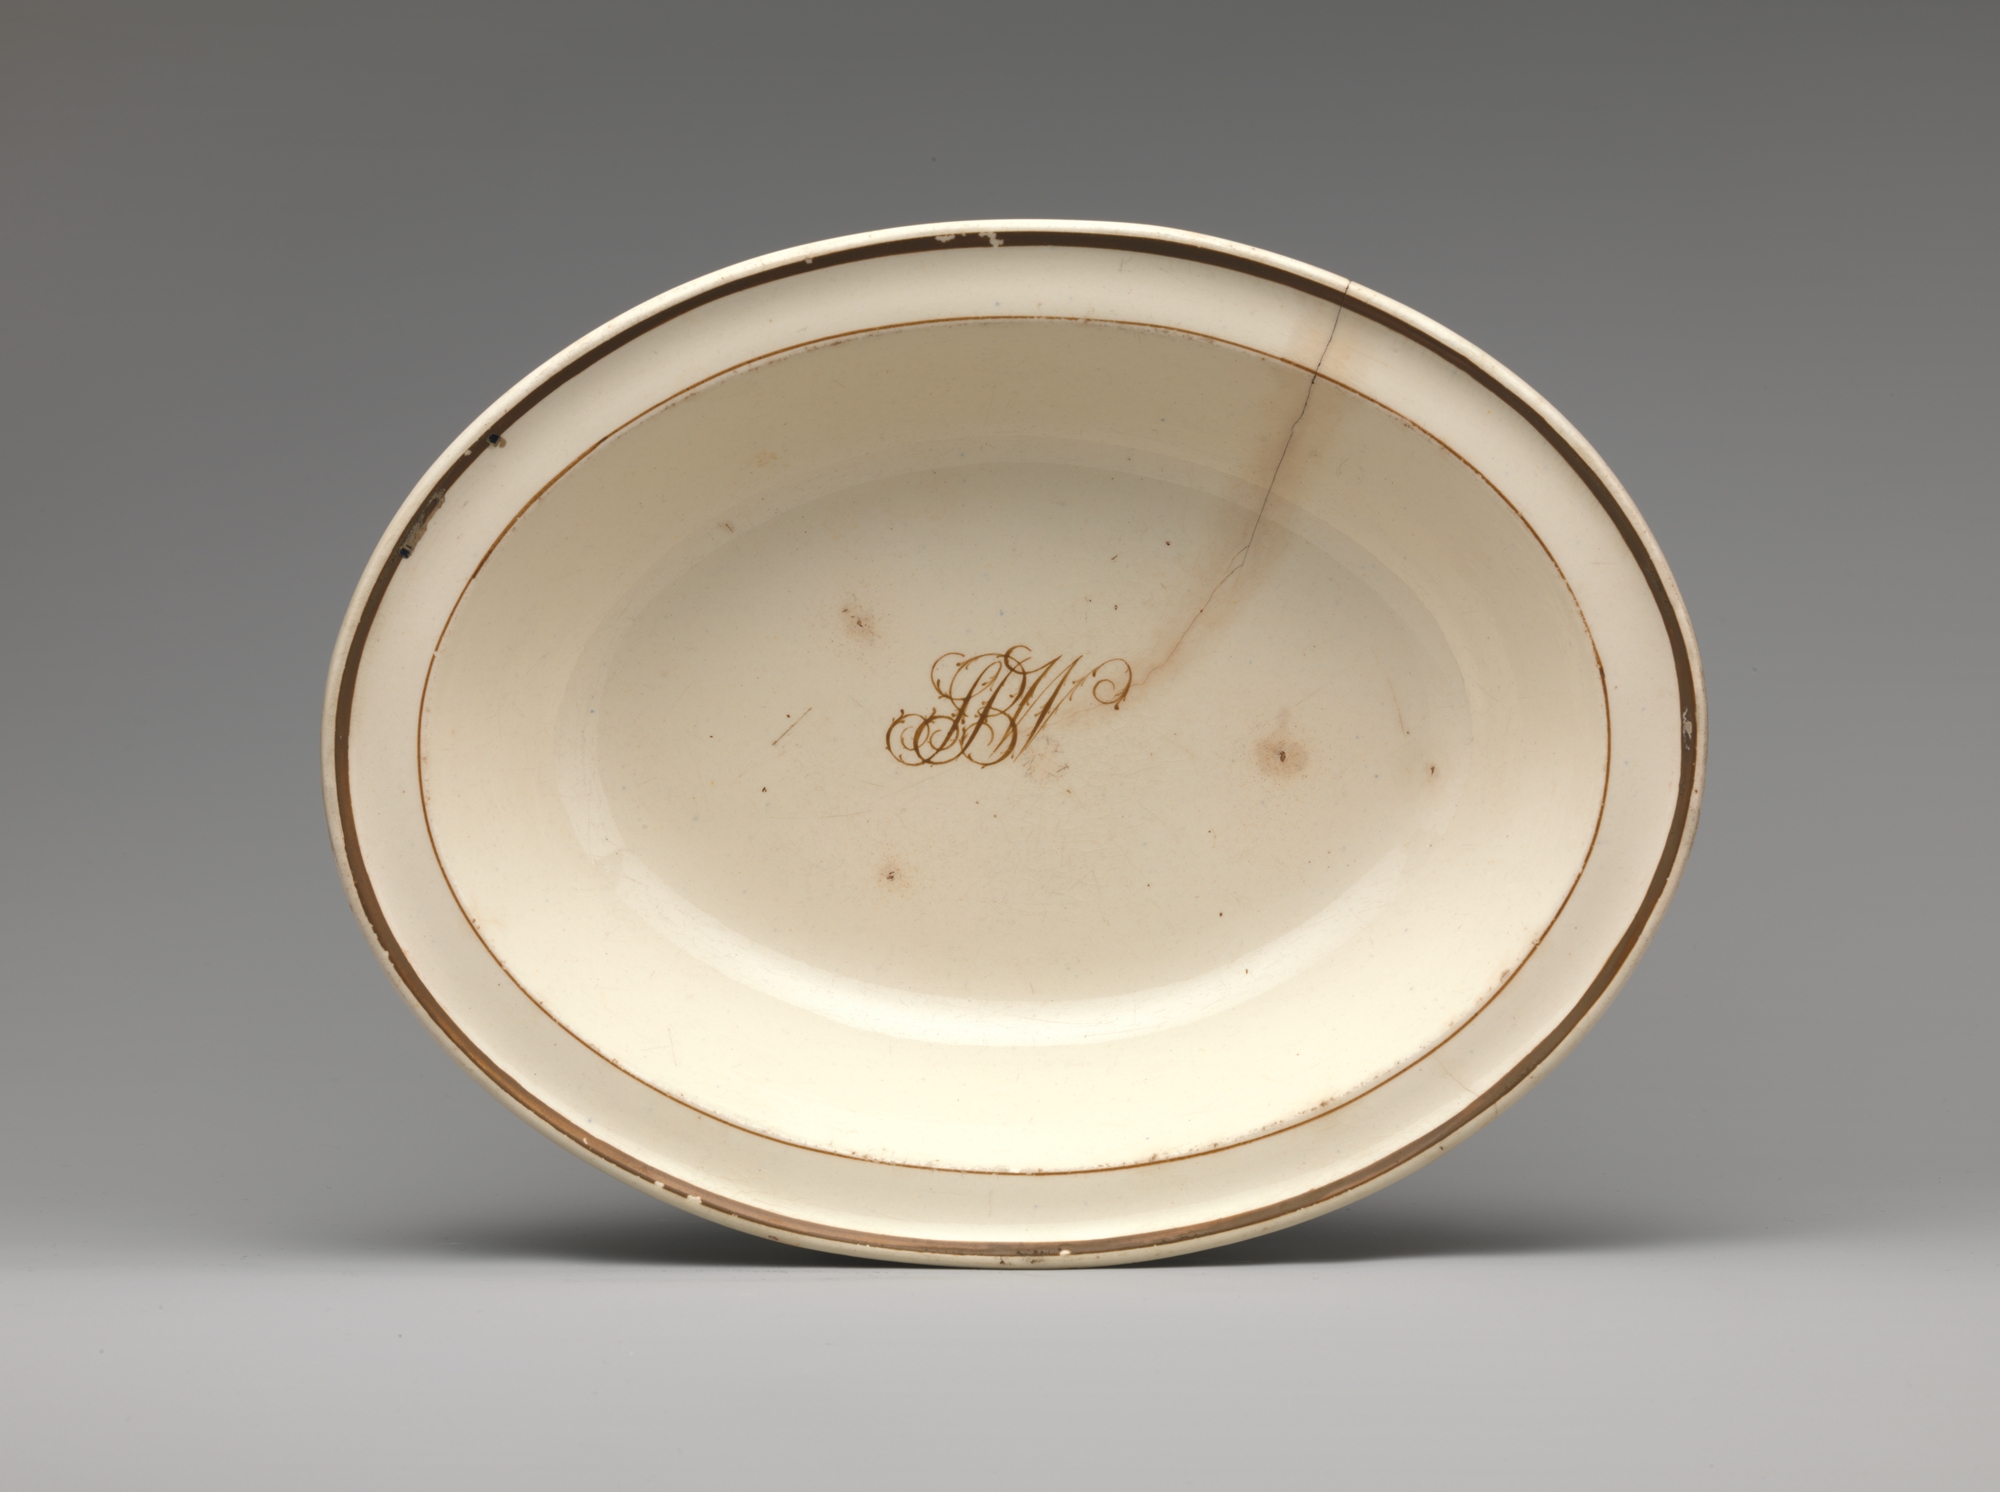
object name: dish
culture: british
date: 1750-1775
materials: earthenware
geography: england